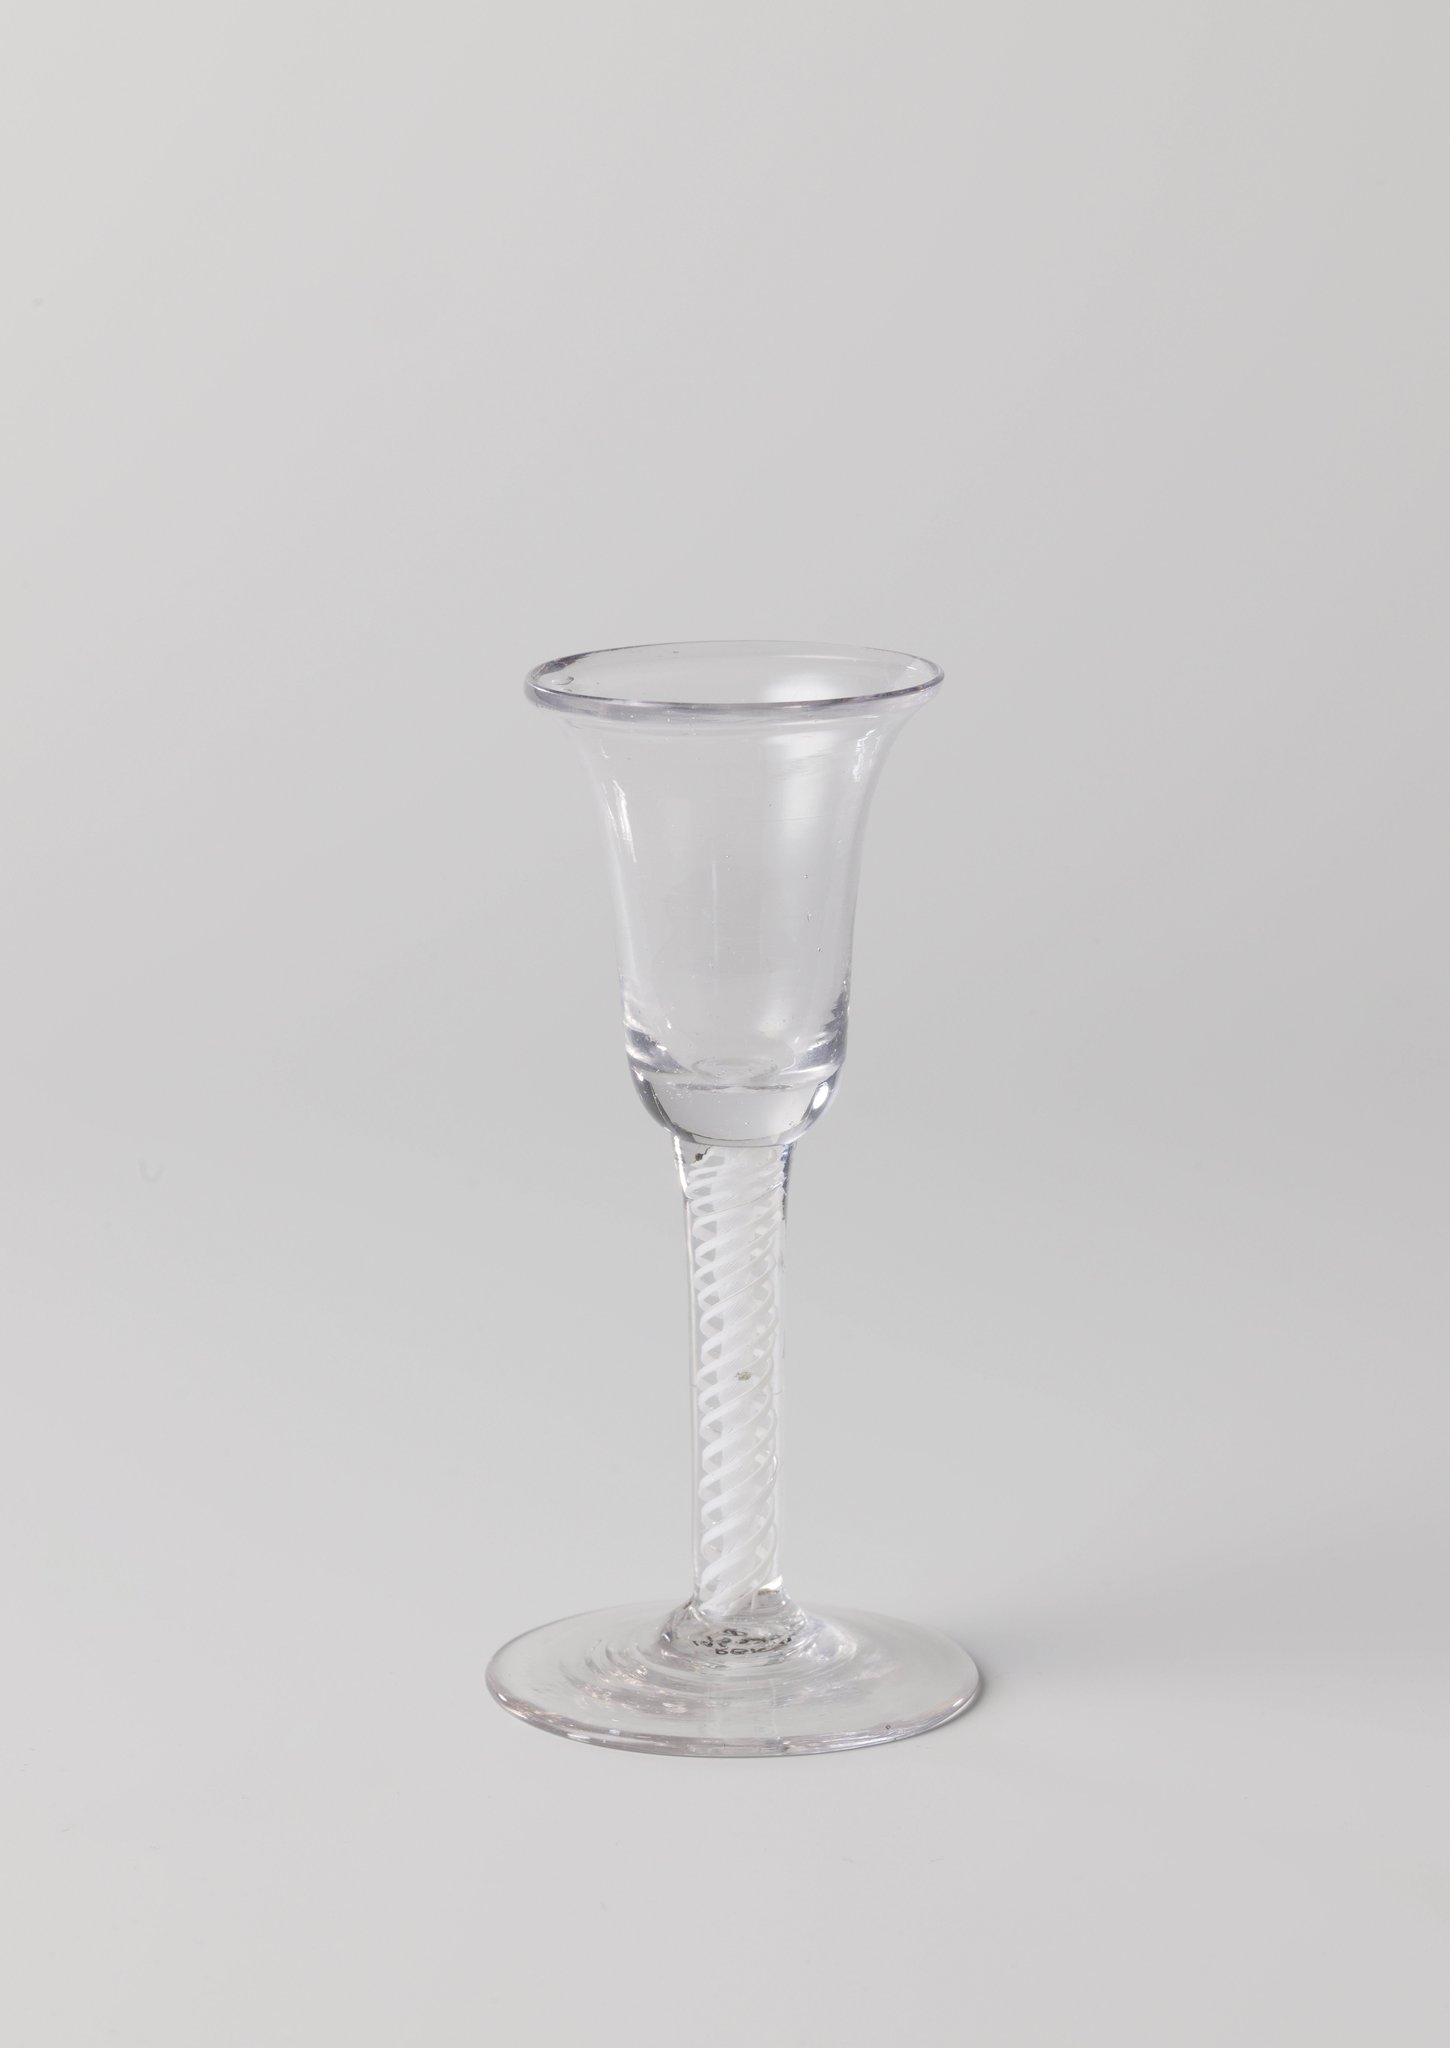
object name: slingerglas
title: Slingerglas met klokvormige kelk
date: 1750-1775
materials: glass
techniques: glassblowing, vetro a retorti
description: Slingerglas met platte voet en rechte stam. In de stam opaak witte slingers rond witte netwerkspiraal. Klokvormige kelk.